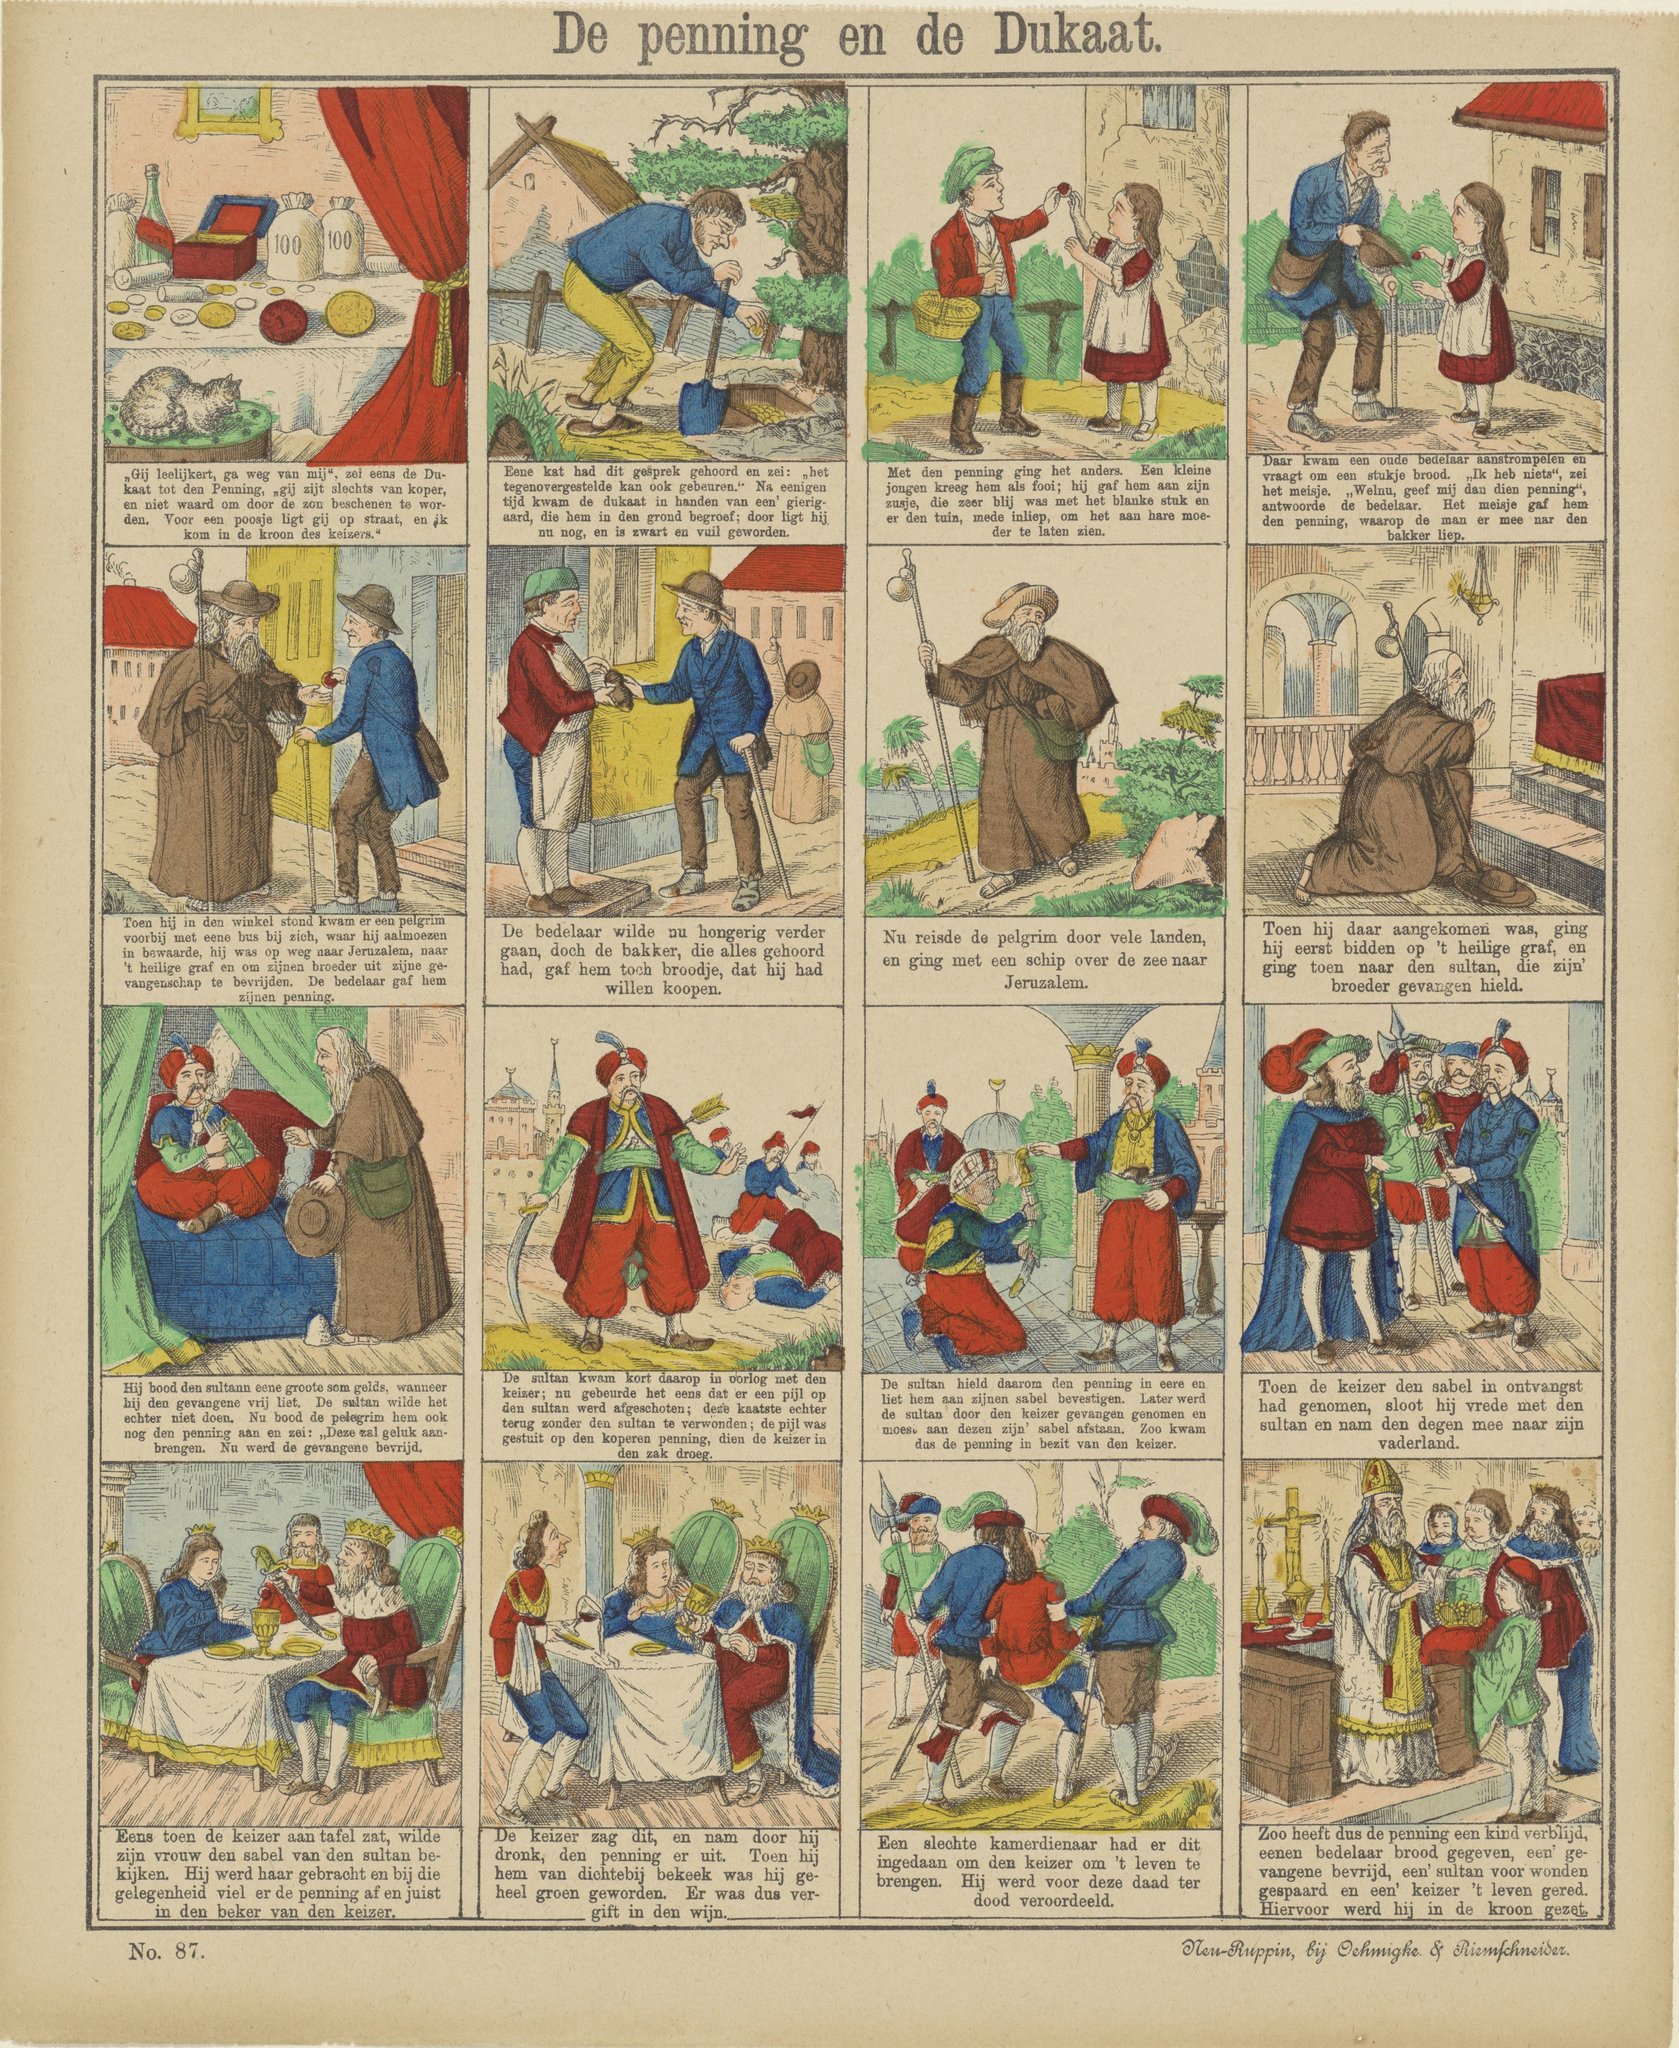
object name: popular print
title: De penning en de dukaat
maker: Anonymous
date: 1828-1937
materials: paper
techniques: hand coloring, letterpress printing, lithograph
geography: neuruppin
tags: coin, tales and fairy tales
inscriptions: collector's mark: Lugt 2760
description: Blad met 16 voorstellingen uit het verhaal van de penning en de dukaat. Onder elke afbeelding een onderschrift. Genummerd linksonder: No. 87.